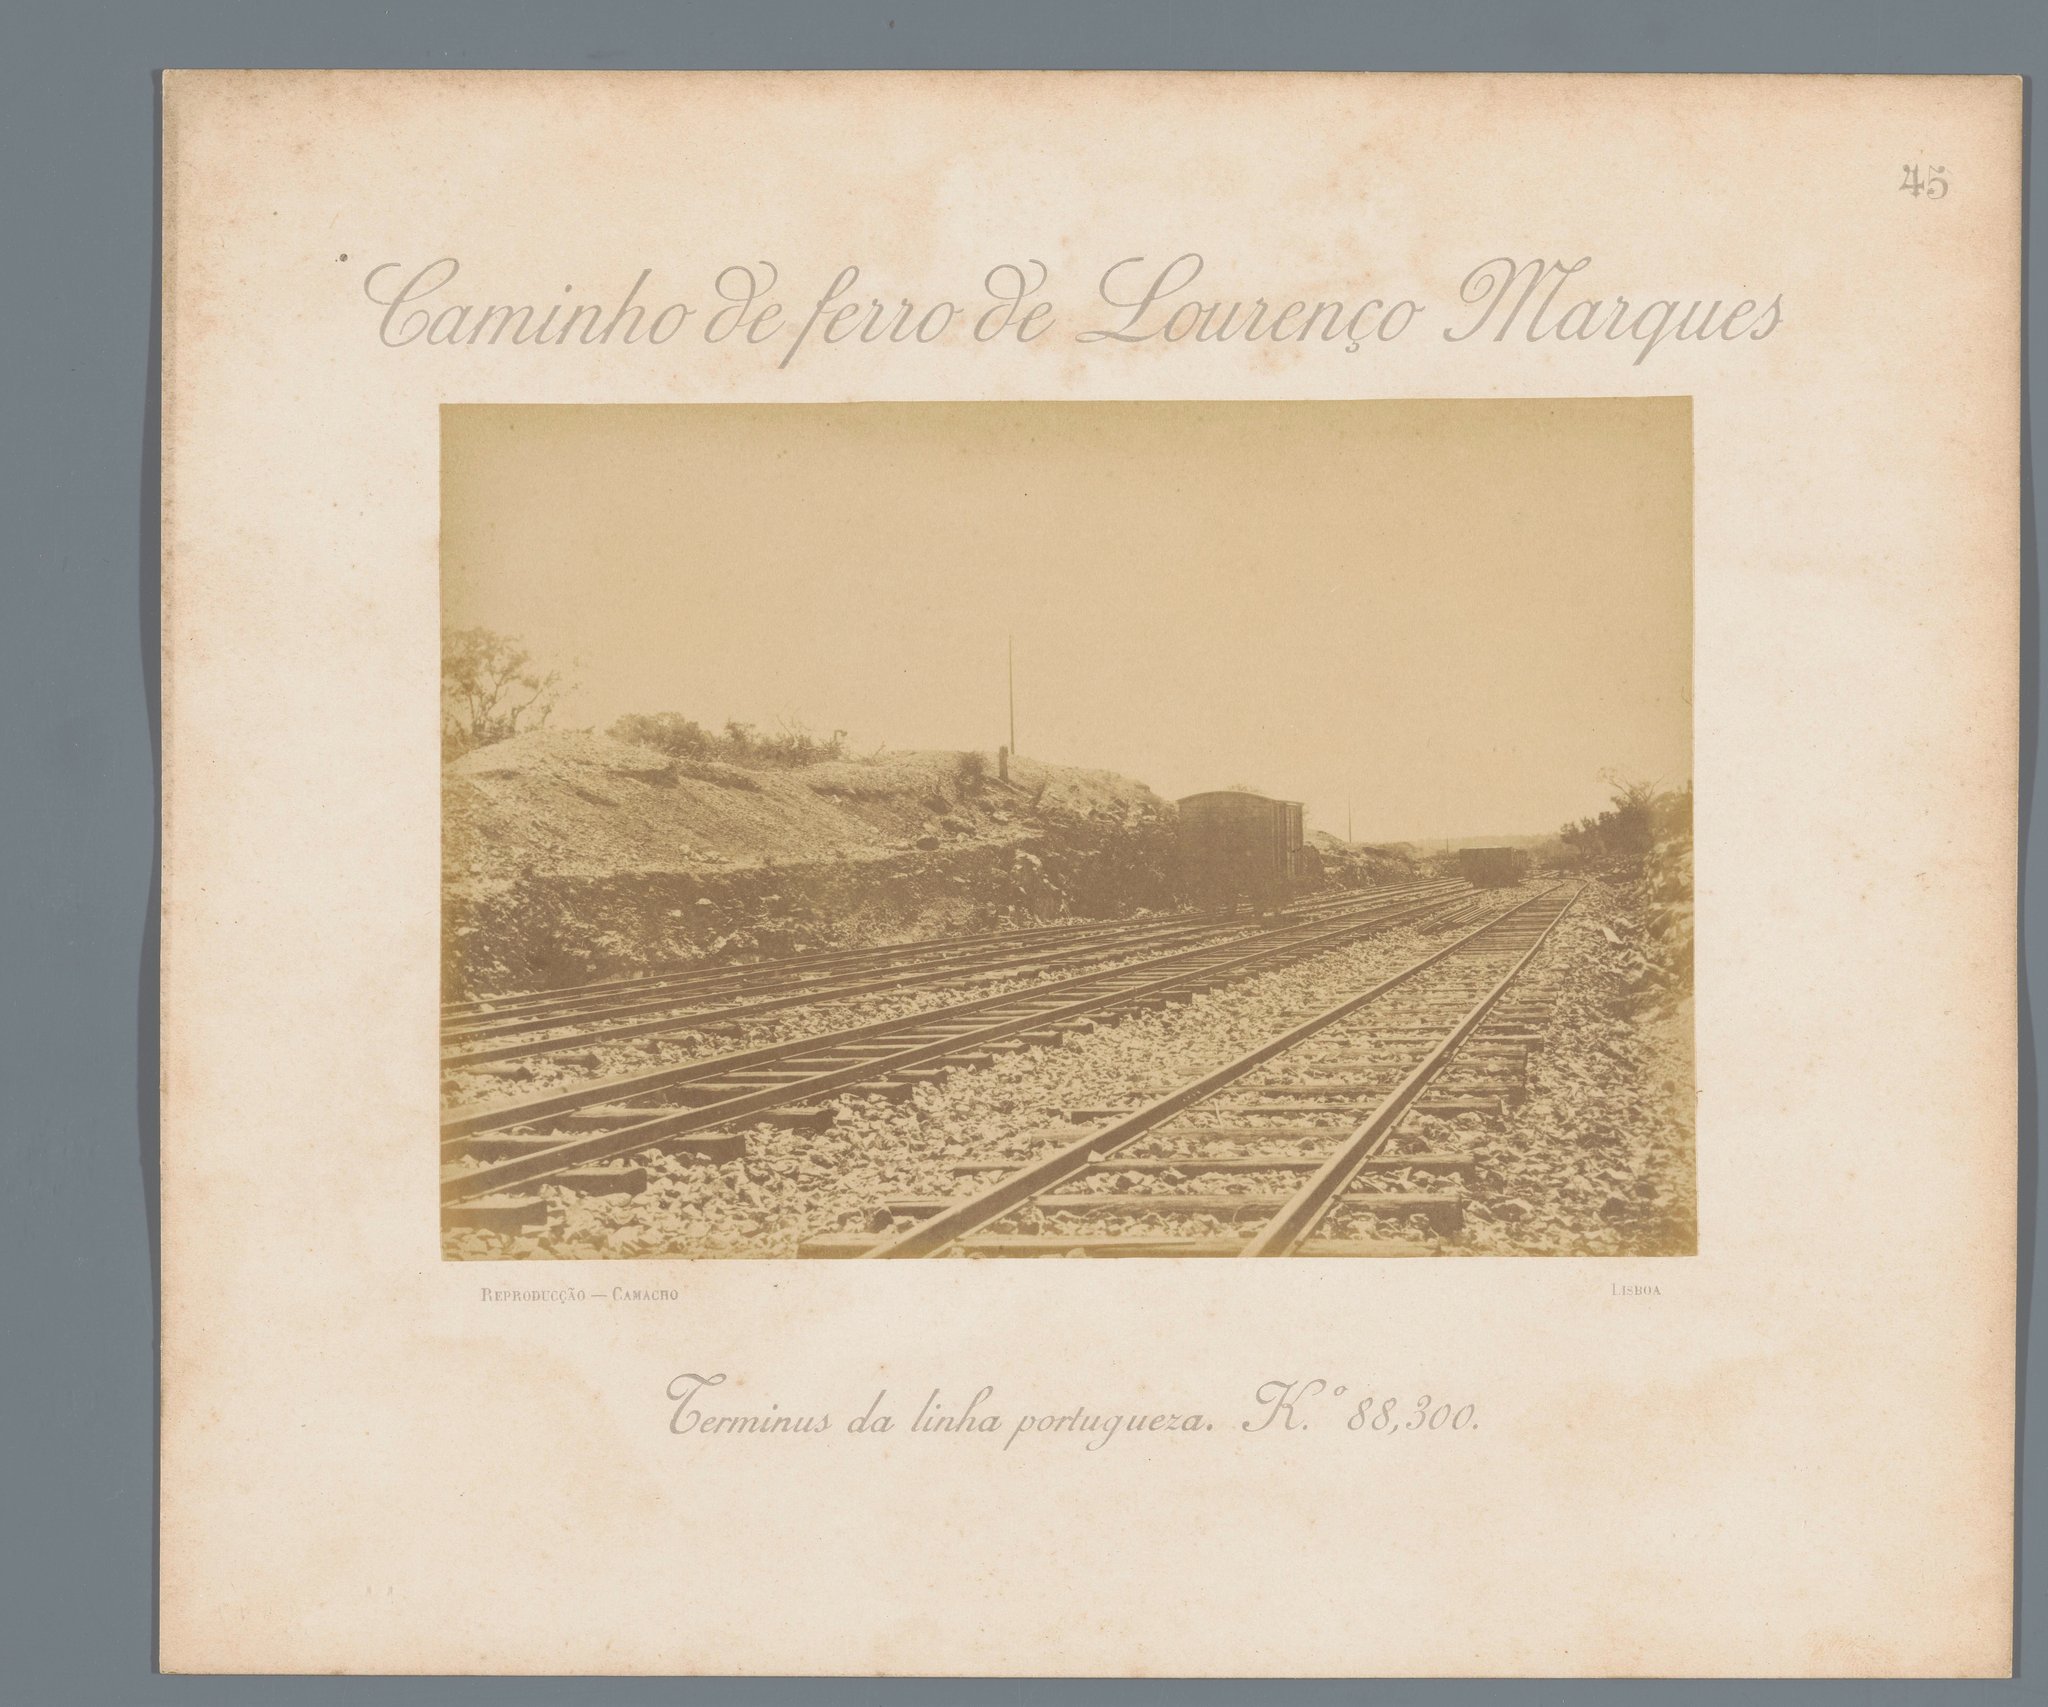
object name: photograph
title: Terminus da linha portugueza K. º88,300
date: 1886-1895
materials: photographic support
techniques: albumen print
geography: lisbon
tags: railway, train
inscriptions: number: ‘45’